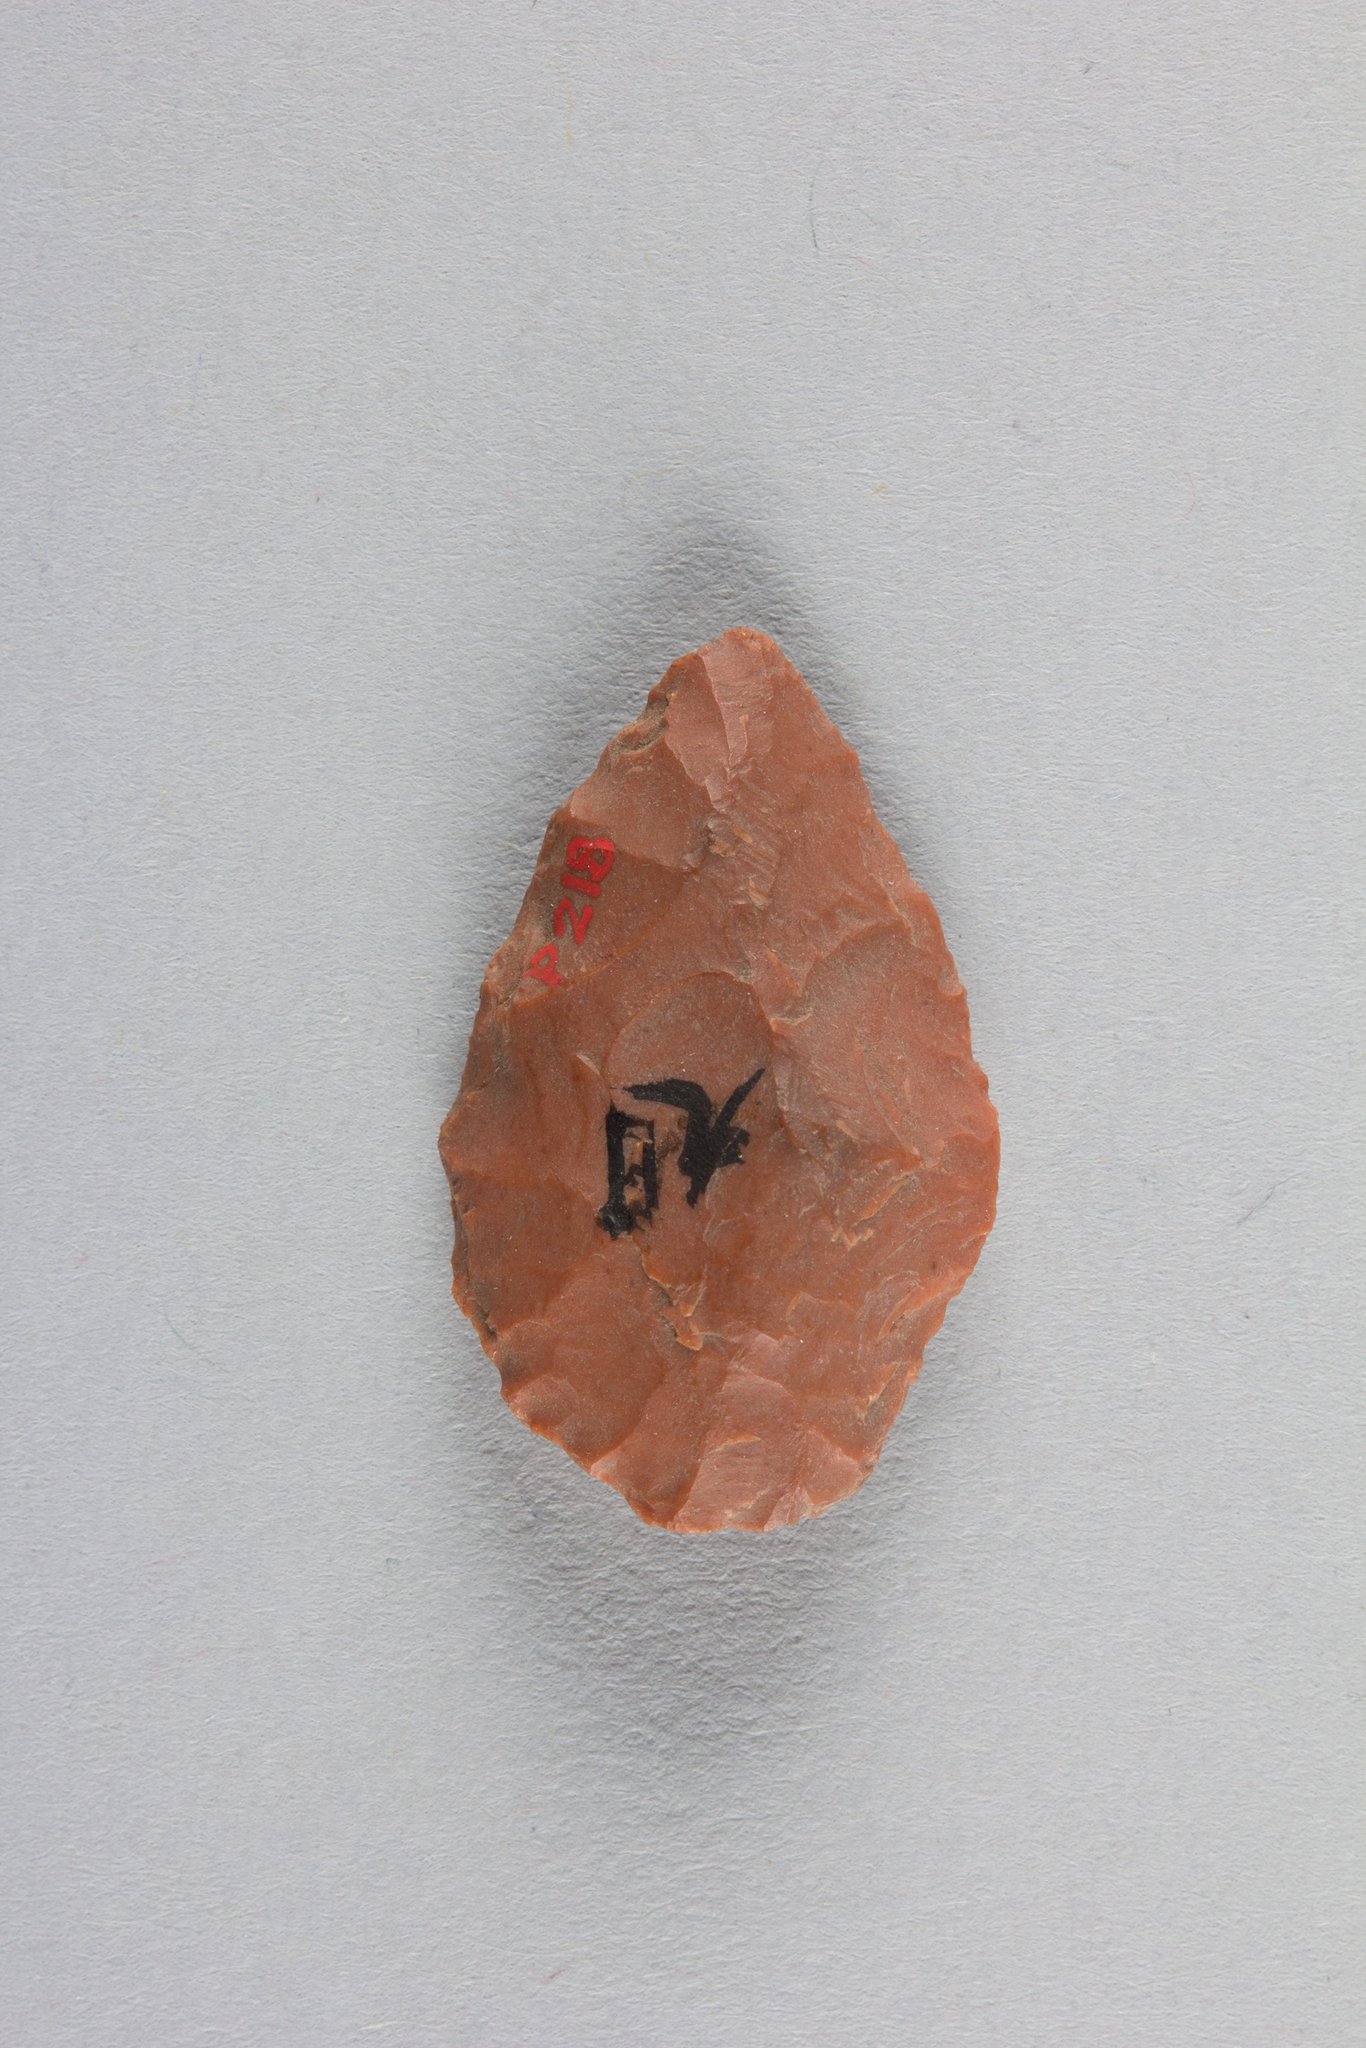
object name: arrowhead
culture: japanese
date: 1500-1000 BCE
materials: stone